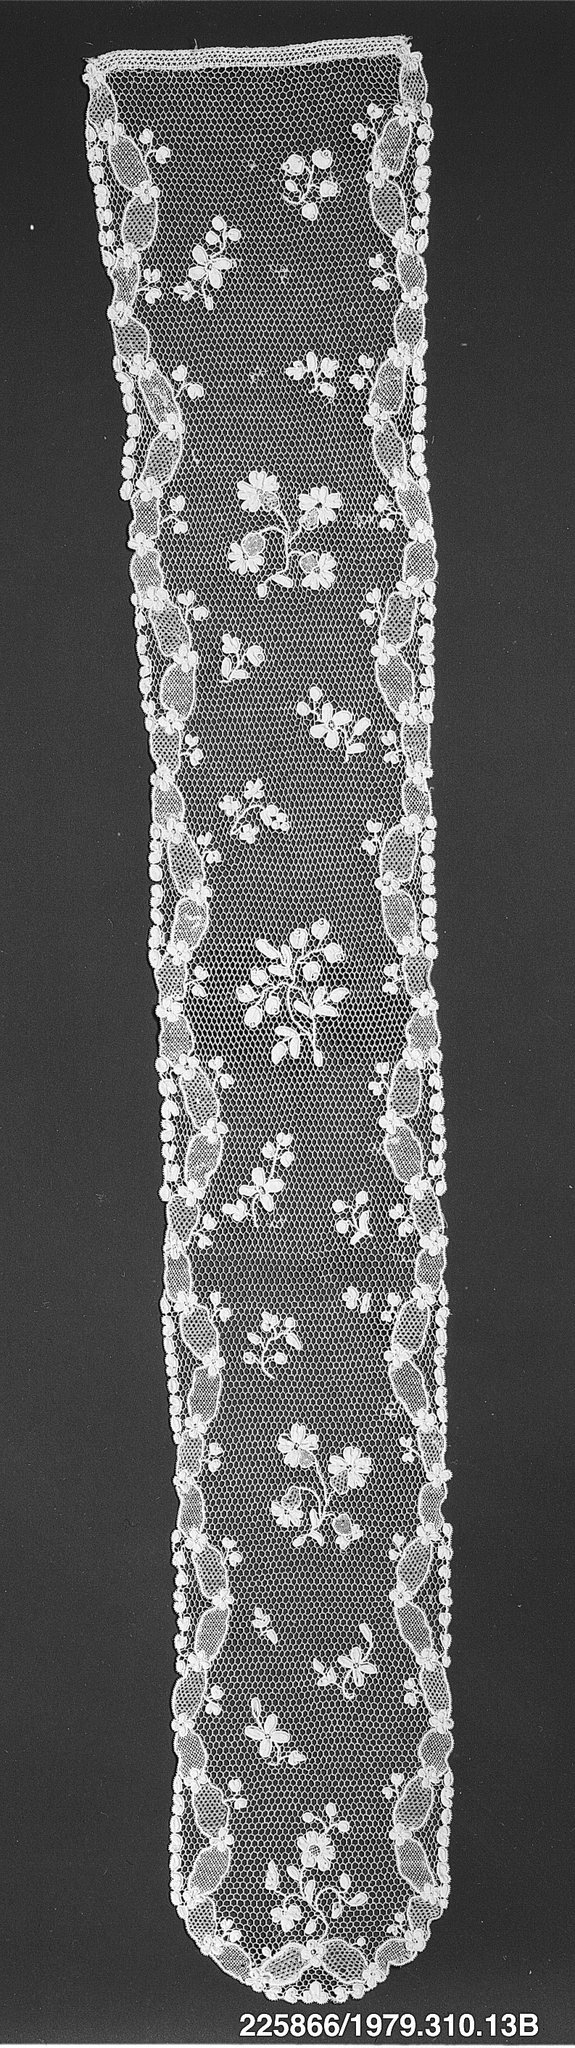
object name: lappet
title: Lappet (one of a pair)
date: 1751-1775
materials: linen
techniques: lace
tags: flowers